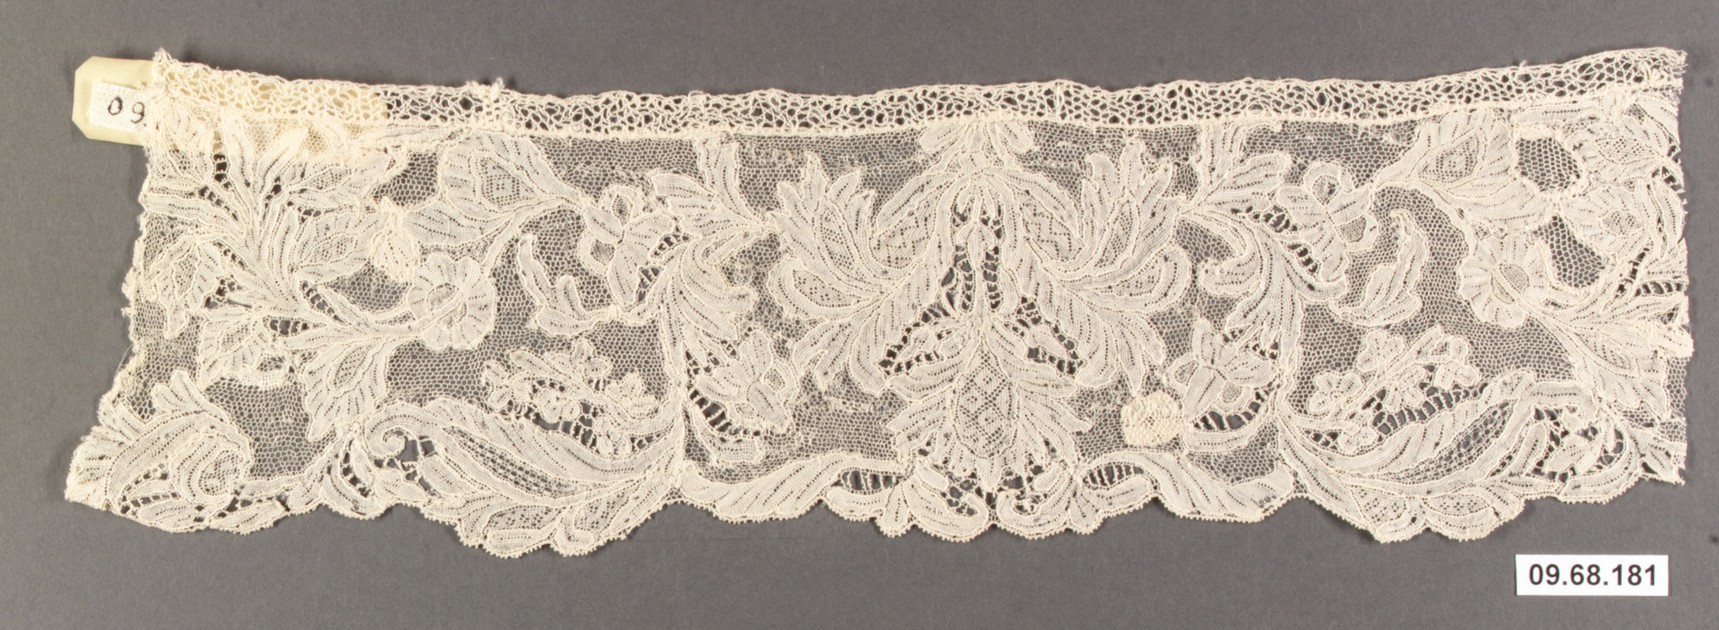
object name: fragment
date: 1701-1800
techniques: lace